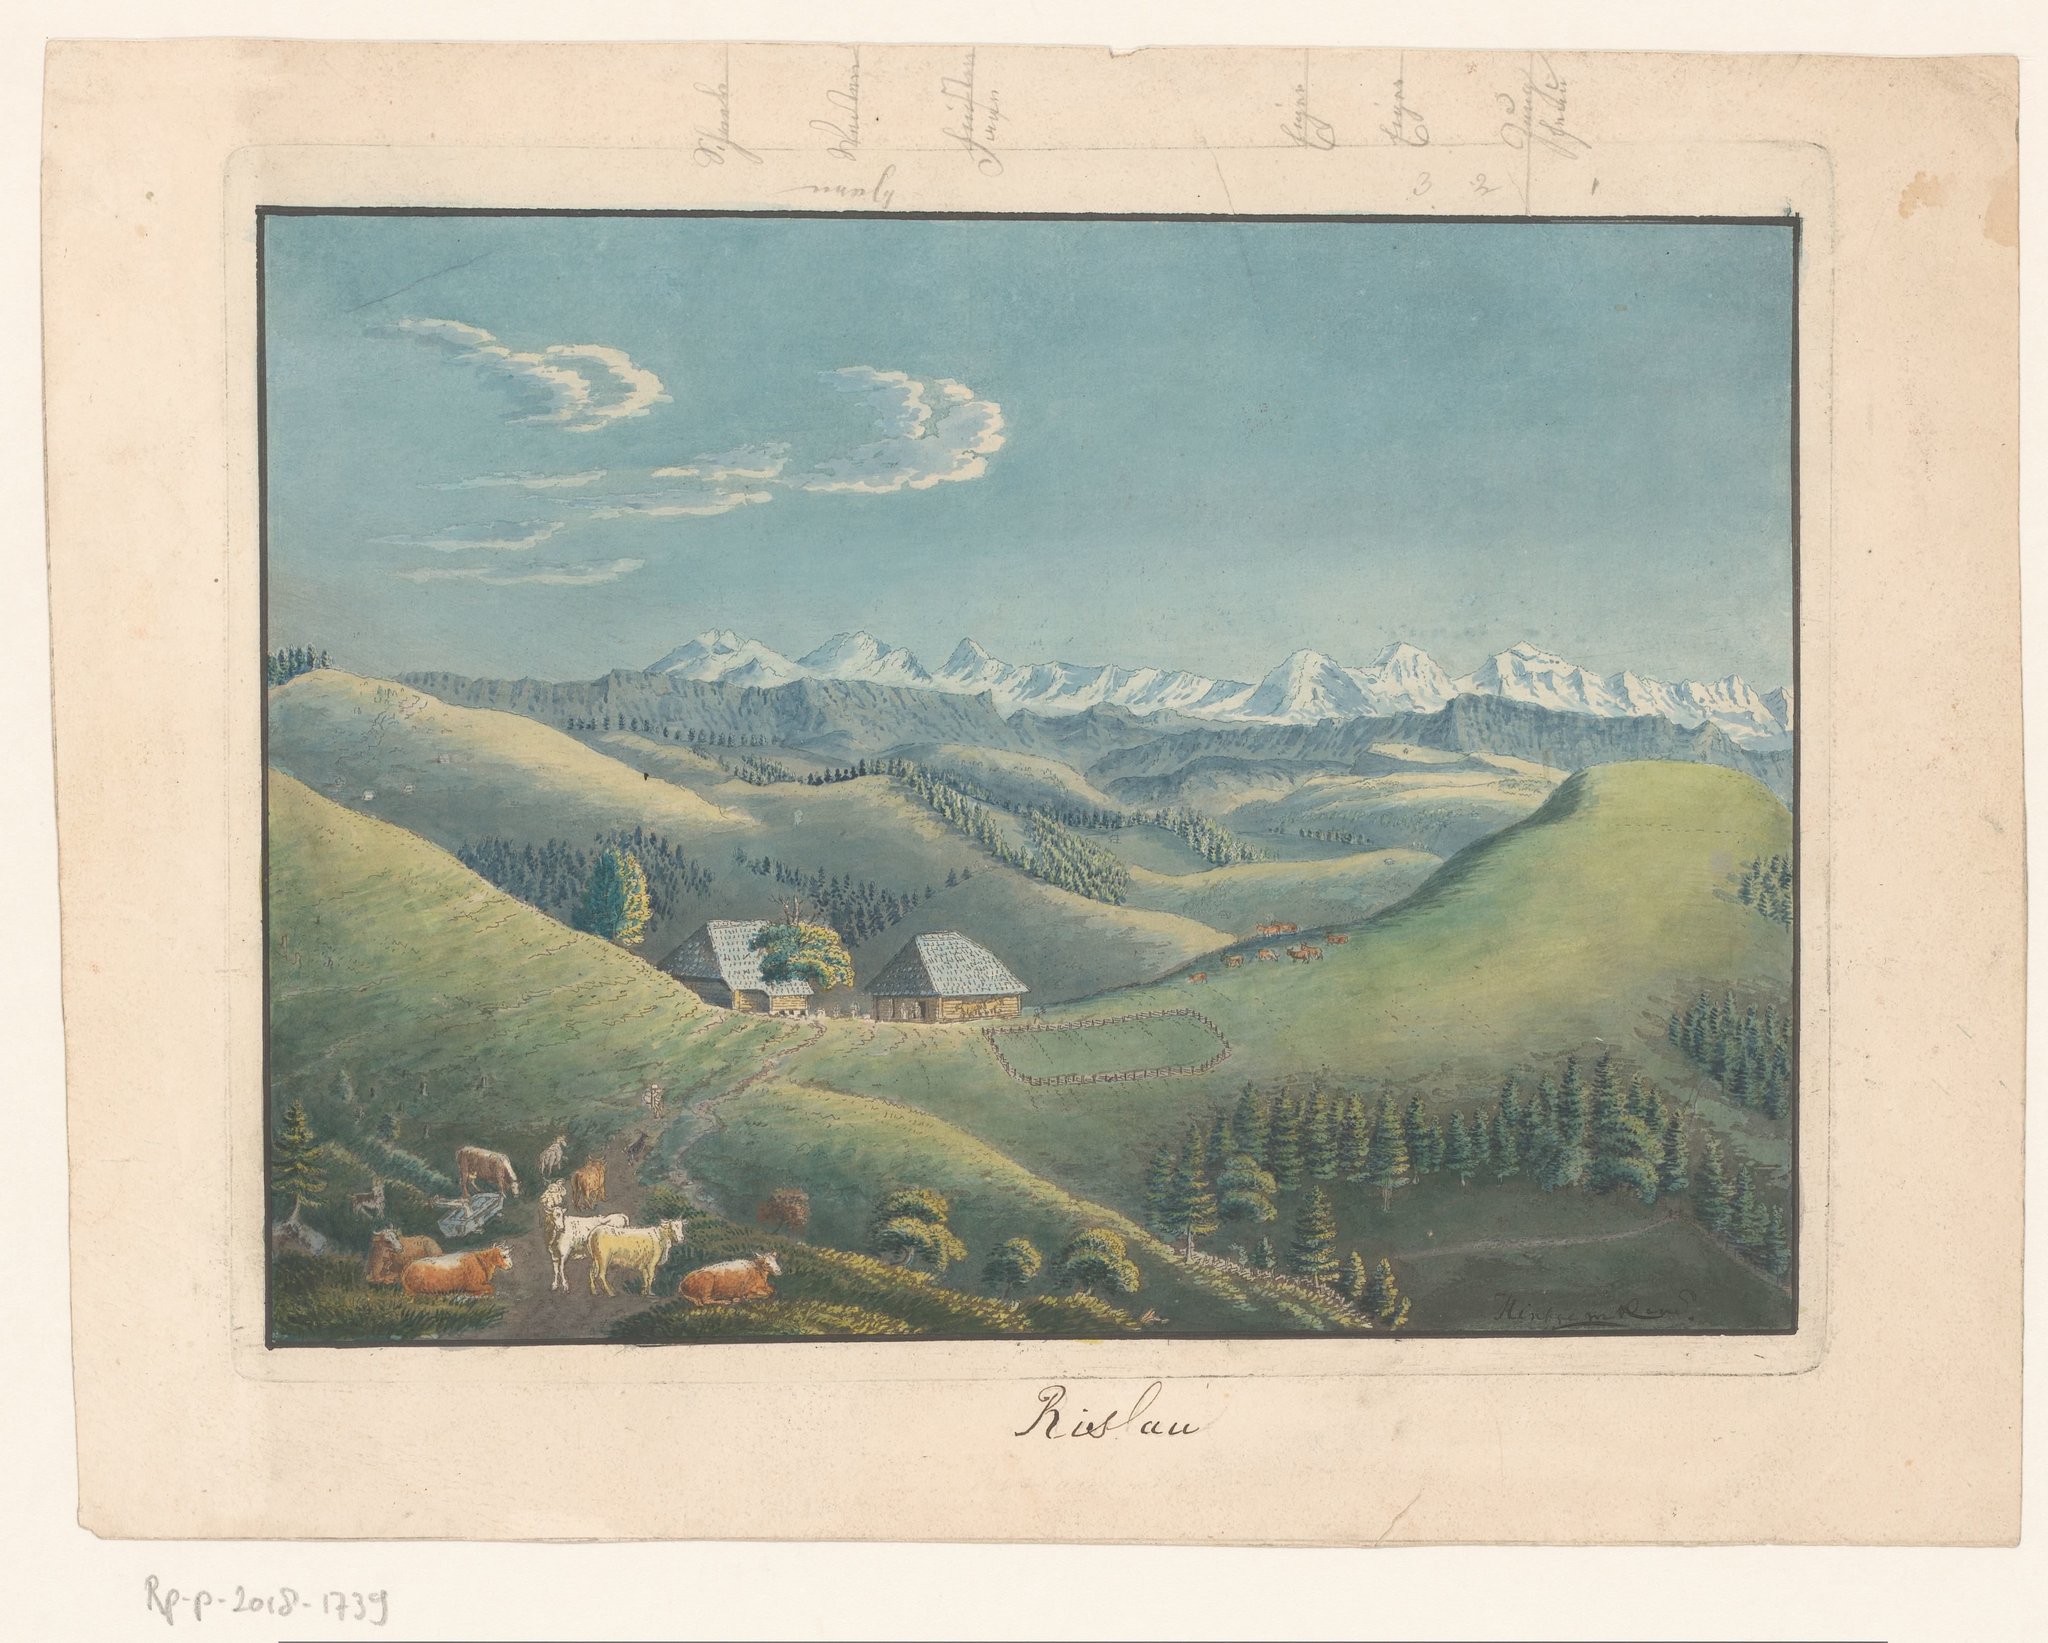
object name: print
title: Gezicht op Rislau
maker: Anonymous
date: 1800-1899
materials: paper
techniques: etching, hand coloring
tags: mountains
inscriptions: collector's mark: Lugt 2228